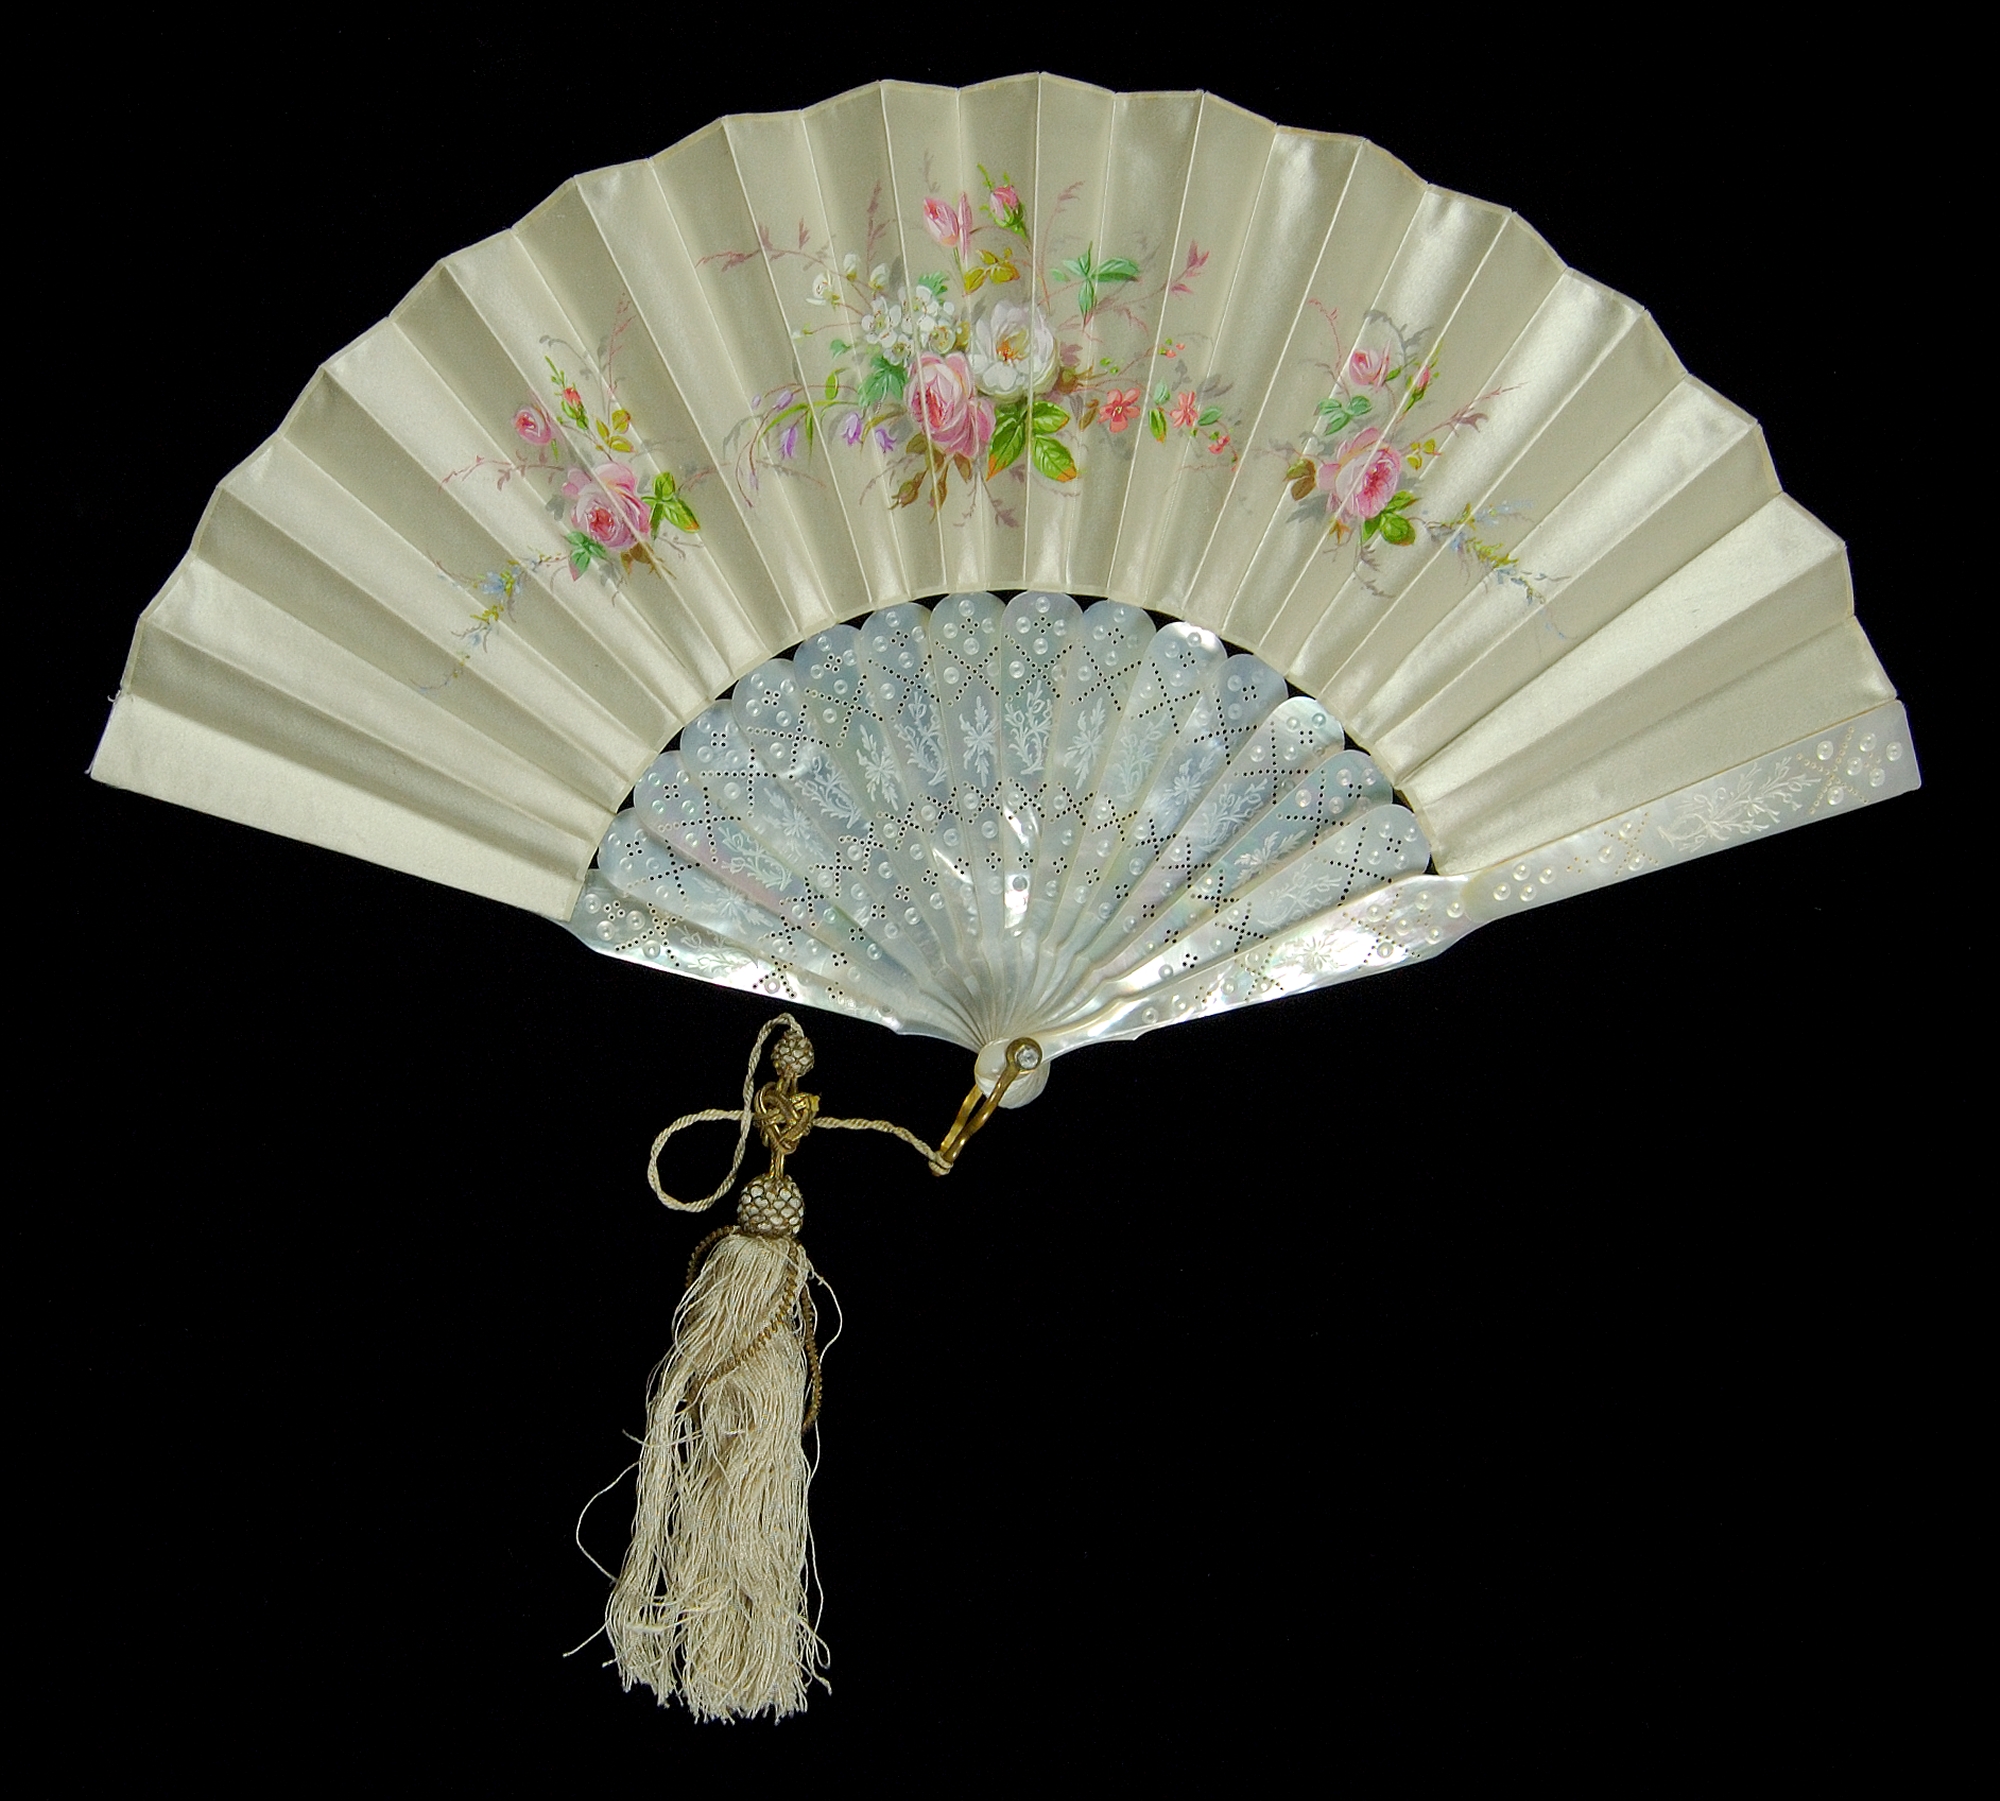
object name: fan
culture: american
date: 1880-1889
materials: metal, mother of pearl, silk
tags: flowers